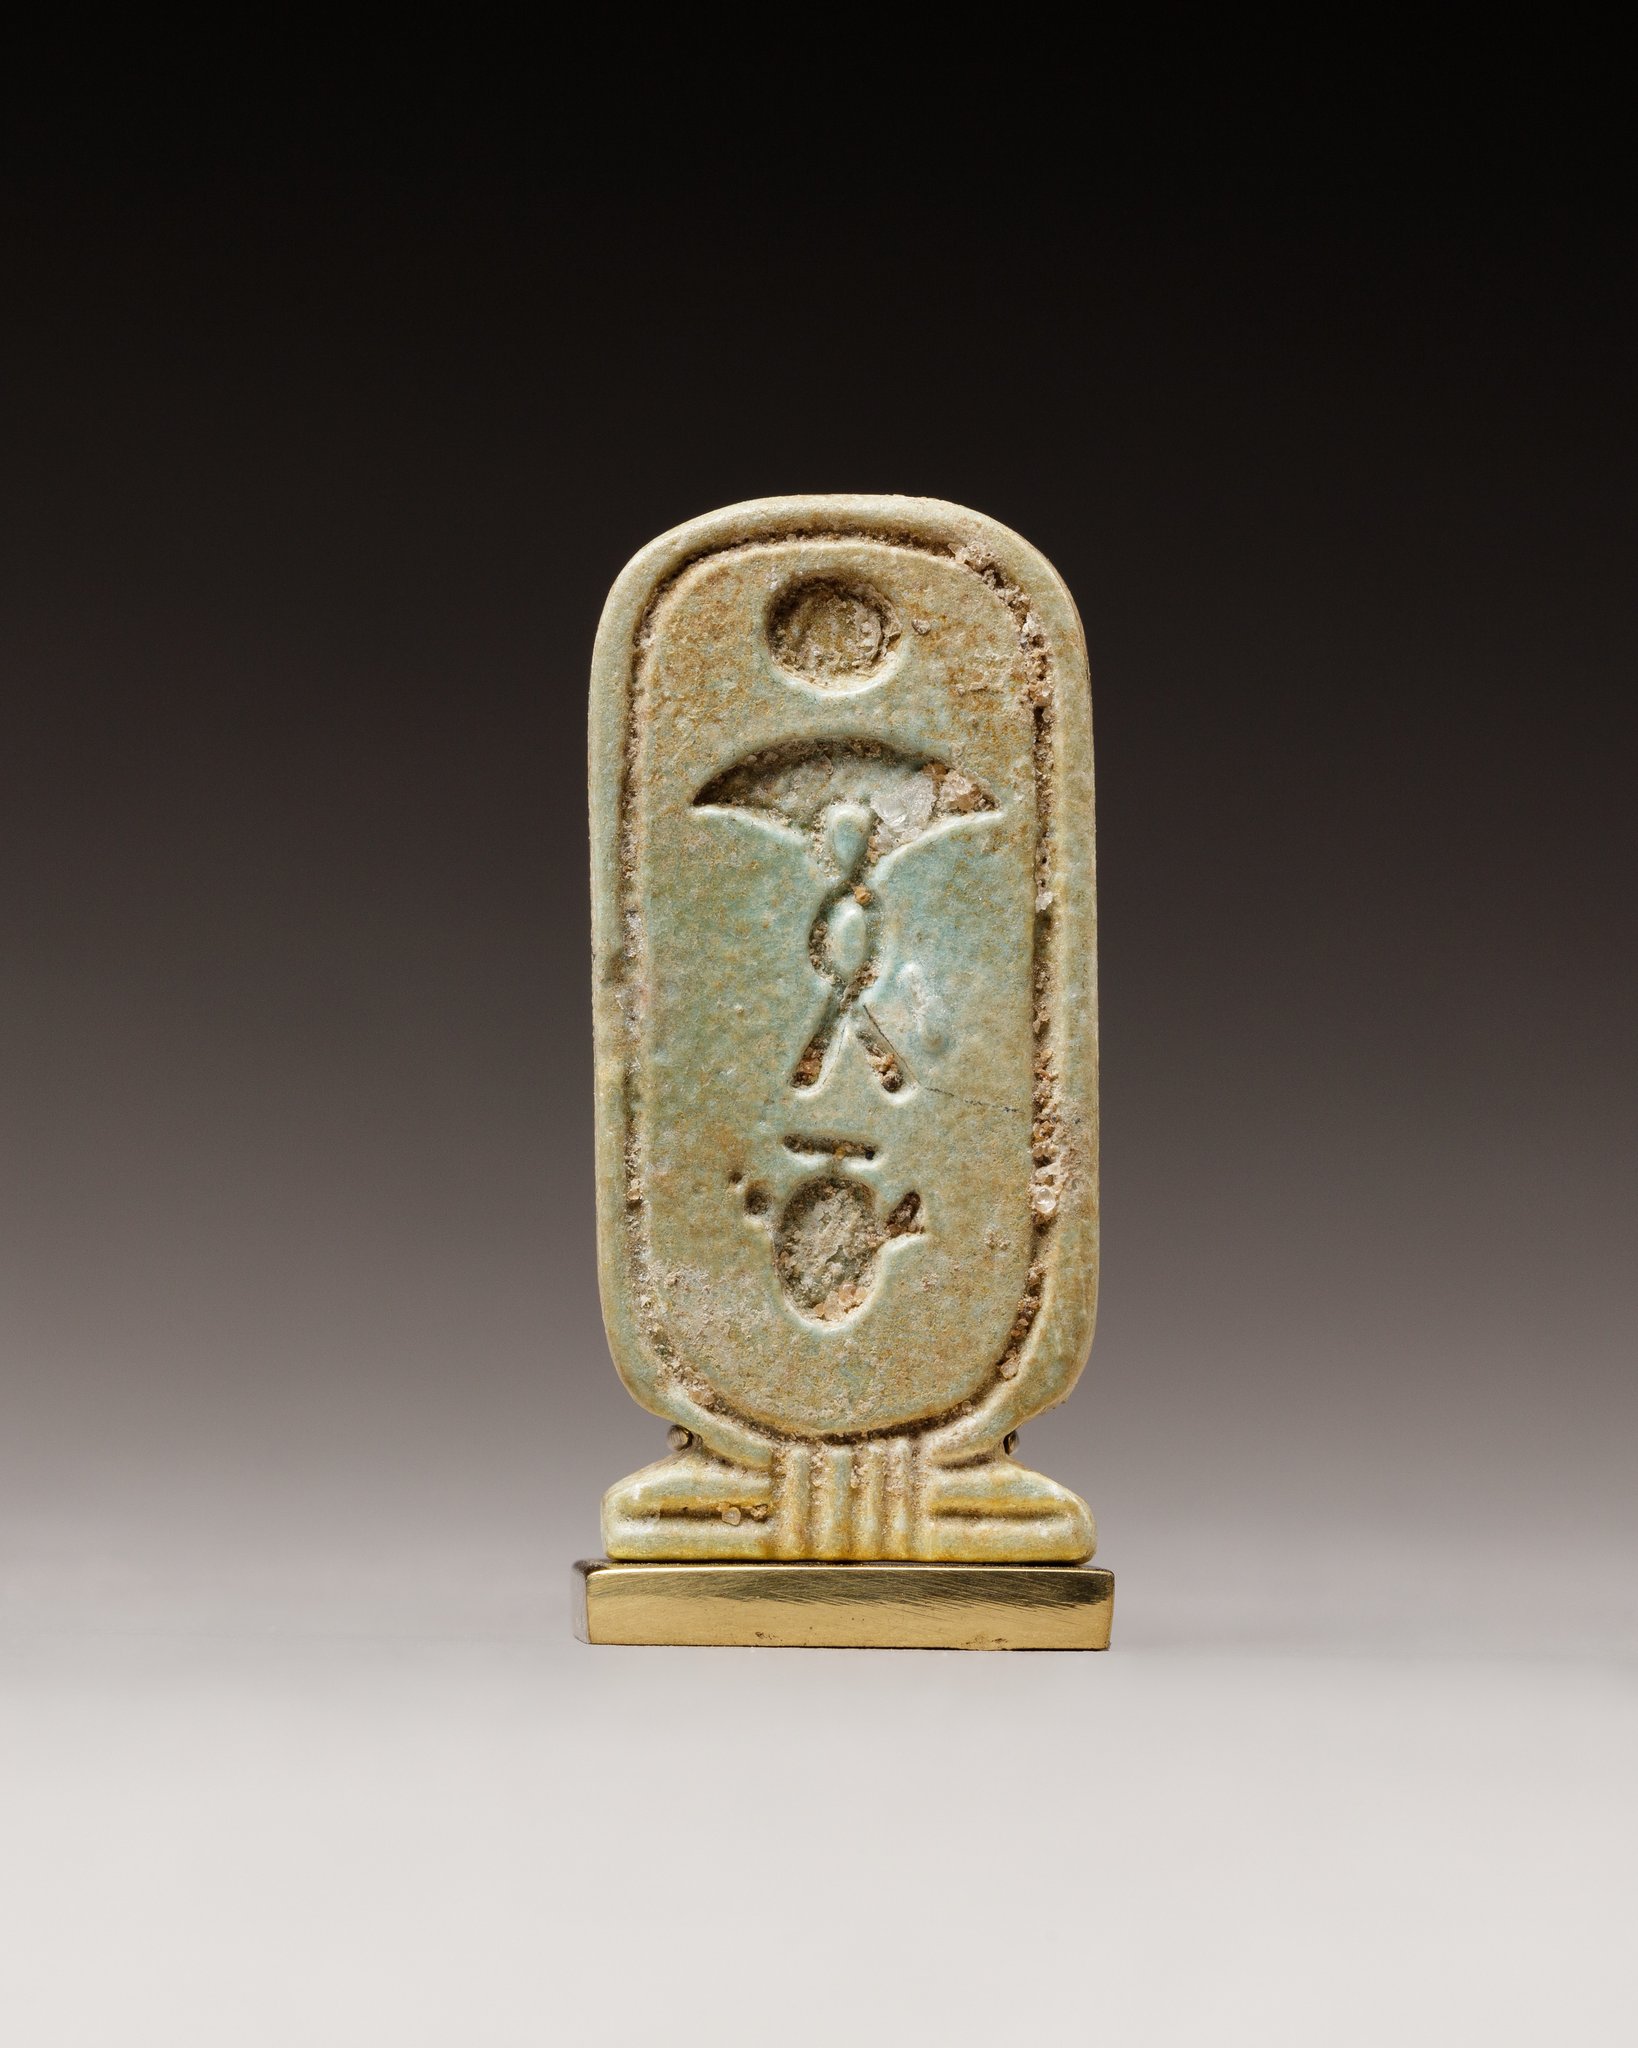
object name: plaque, cartouche, apries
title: Cartouche-shaped plaque with the names of Apries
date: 589-570 BCE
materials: faience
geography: egypt